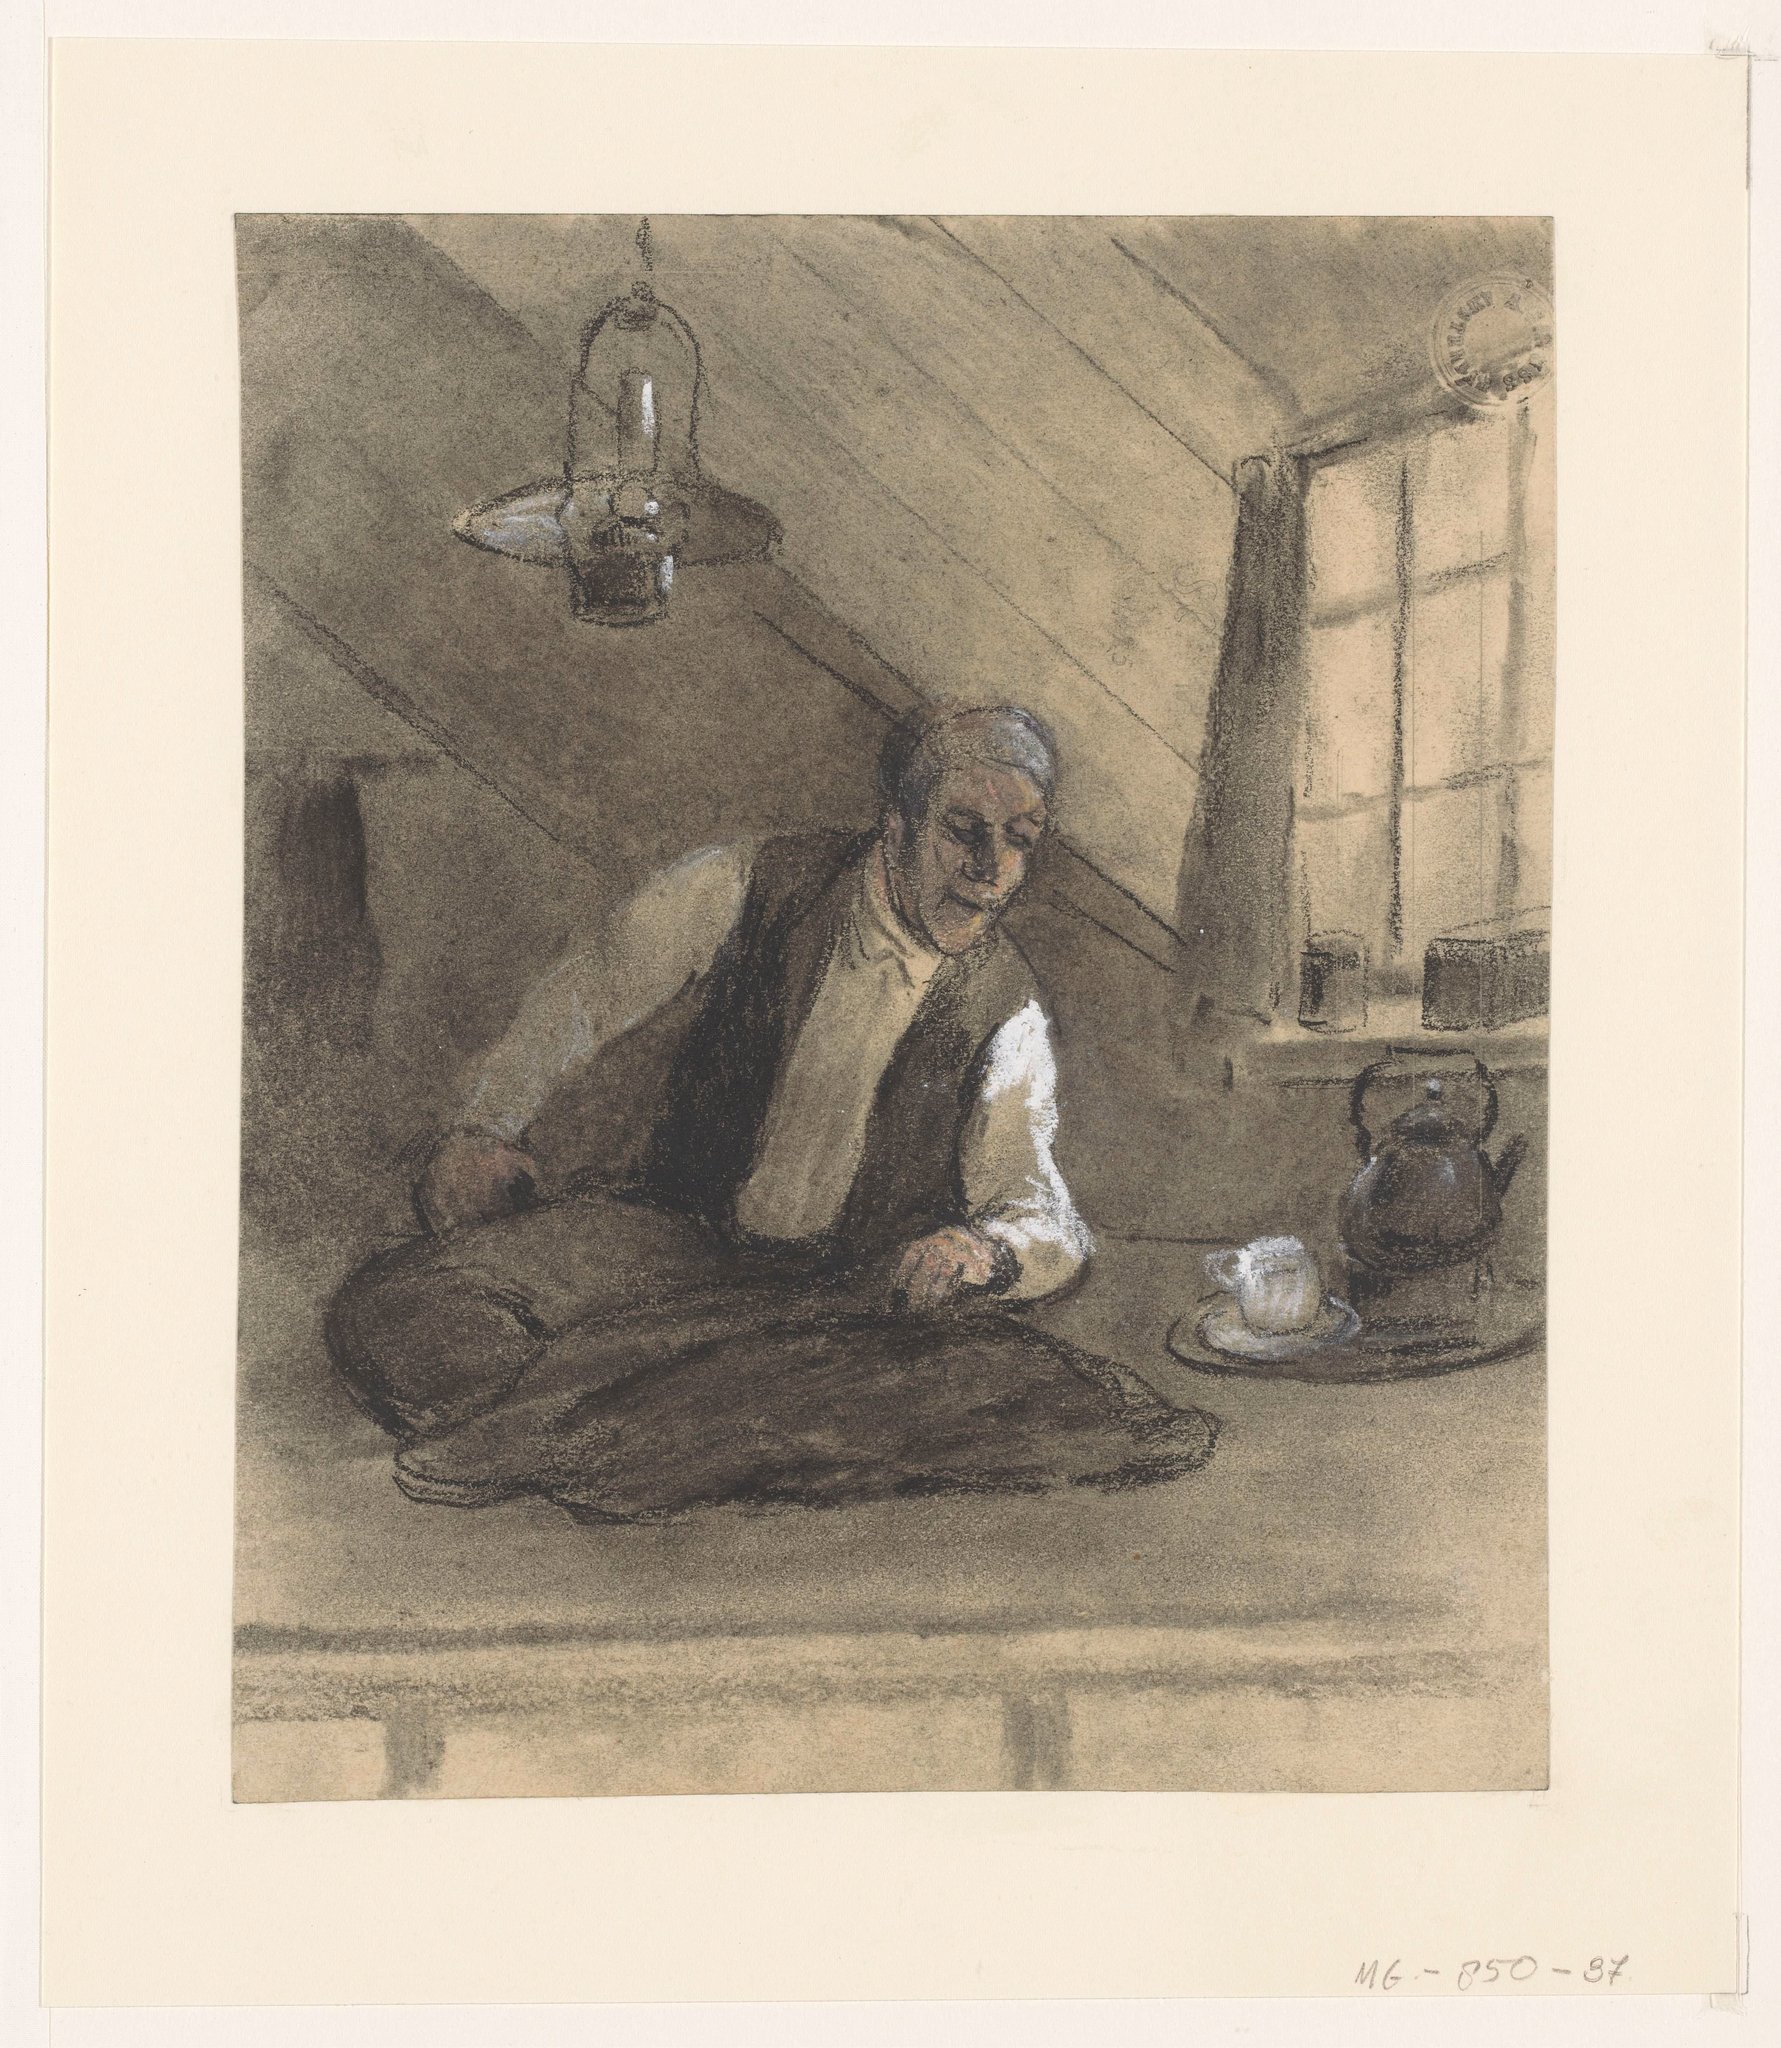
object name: drawing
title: Kleermaker aan het werk op een zolderkamer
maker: herman heijenbrock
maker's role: draughtsman, painter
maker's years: 1871-1948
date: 1881-1925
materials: chalk, paper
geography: netherlands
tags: attic, loft, sitting cross-legged, as tailor at work, tailor, dressmaker, netherlands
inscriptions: stamp: ‘A.J. Nuss Amsterdam’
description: De kleermaker zittend werkend aan een kledingstuk, rechts een theeservies en het raam van de zolderkamer; aan het plafond hangt een olielamp.